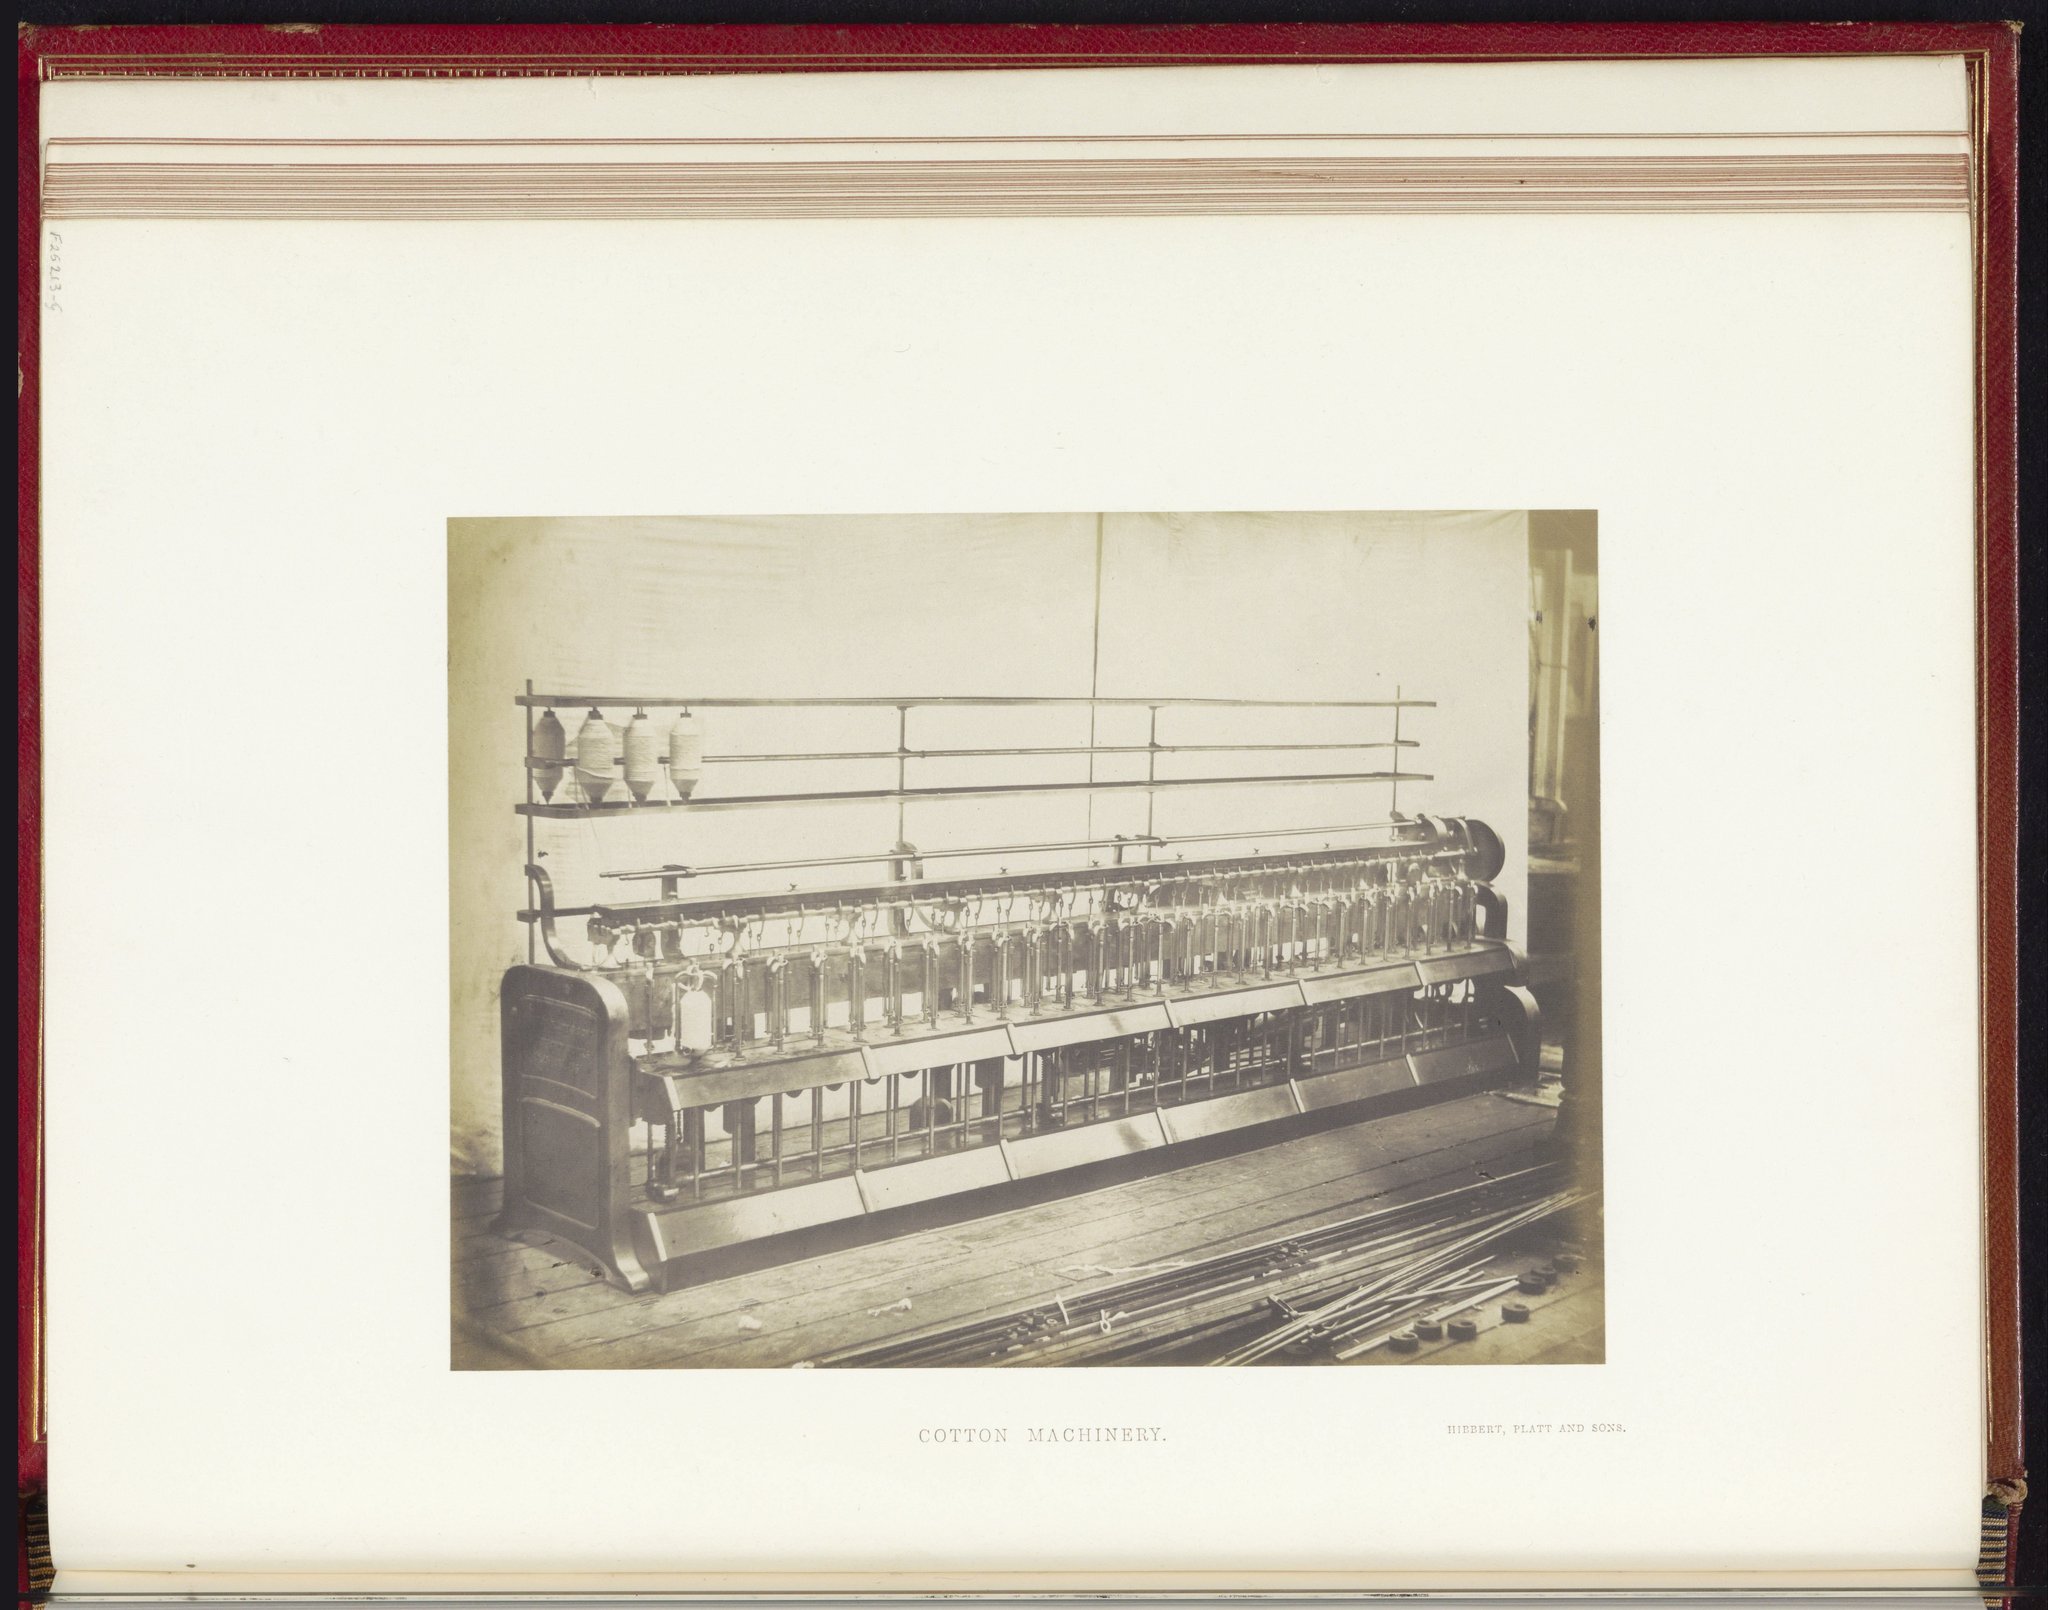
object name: photograph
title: Cotton Machinery. Hibbert, Platt and Sons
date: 1851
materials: photographic support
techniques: salted paper print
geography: london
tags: cotton (material ~ textile industry), machines; parts of machines; tools and appliances, london